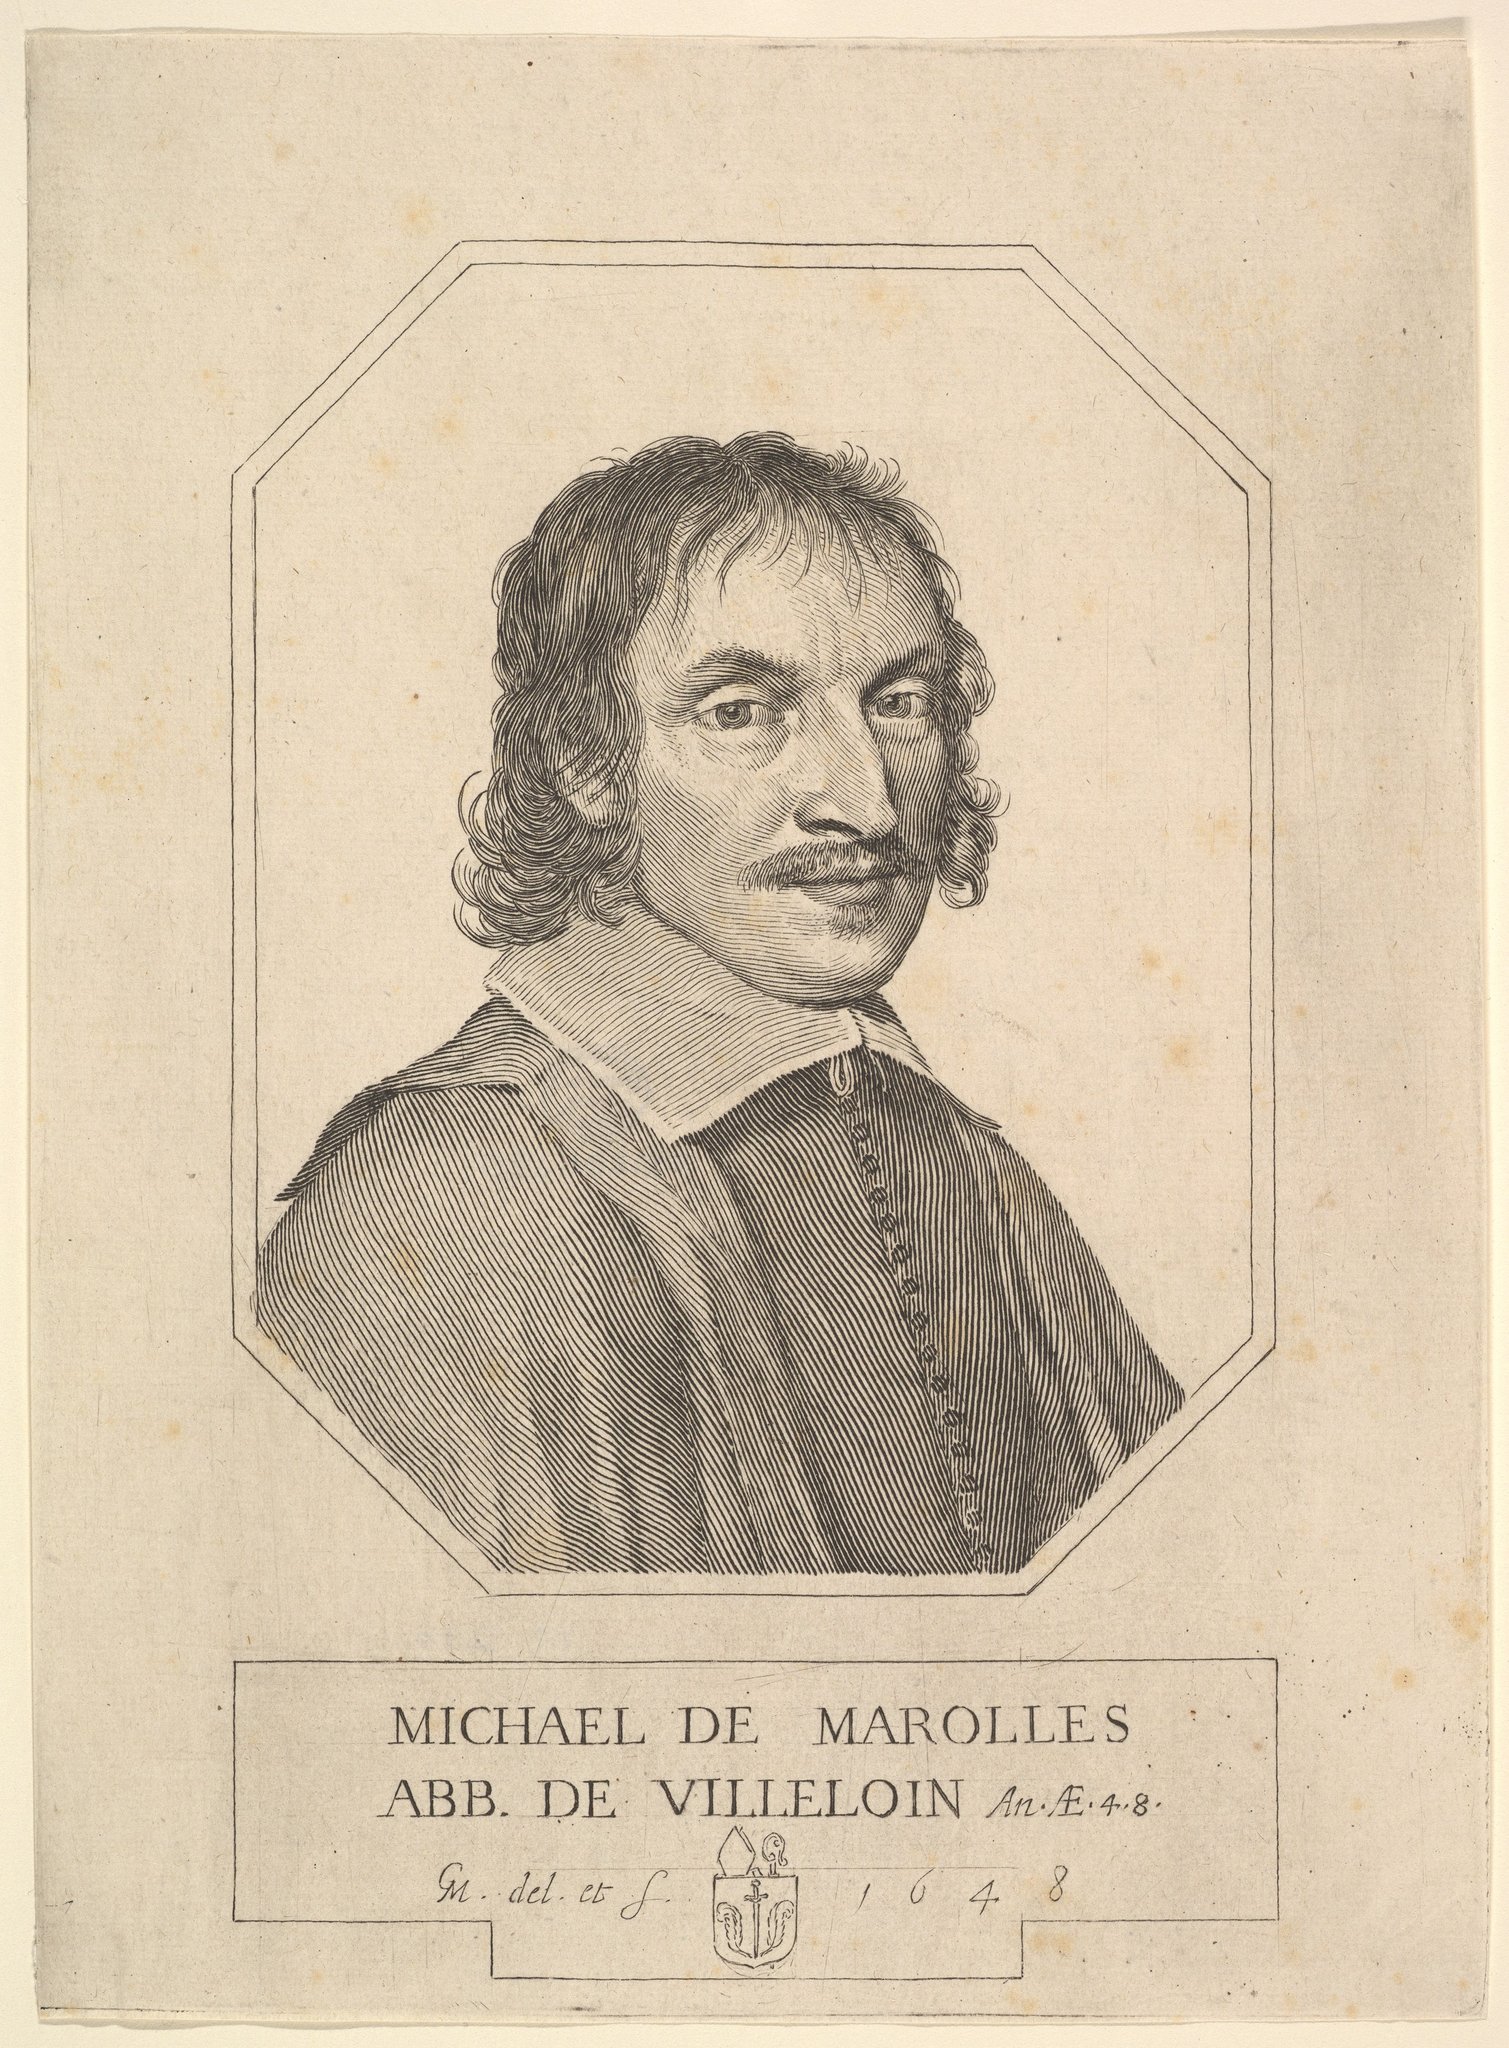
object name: print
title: Portrait of Michel de Marolles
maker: claude mellan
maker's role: artist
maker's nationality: french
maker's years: 1598-1688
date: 1648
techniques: engraving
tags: men,portraits,coat of arms